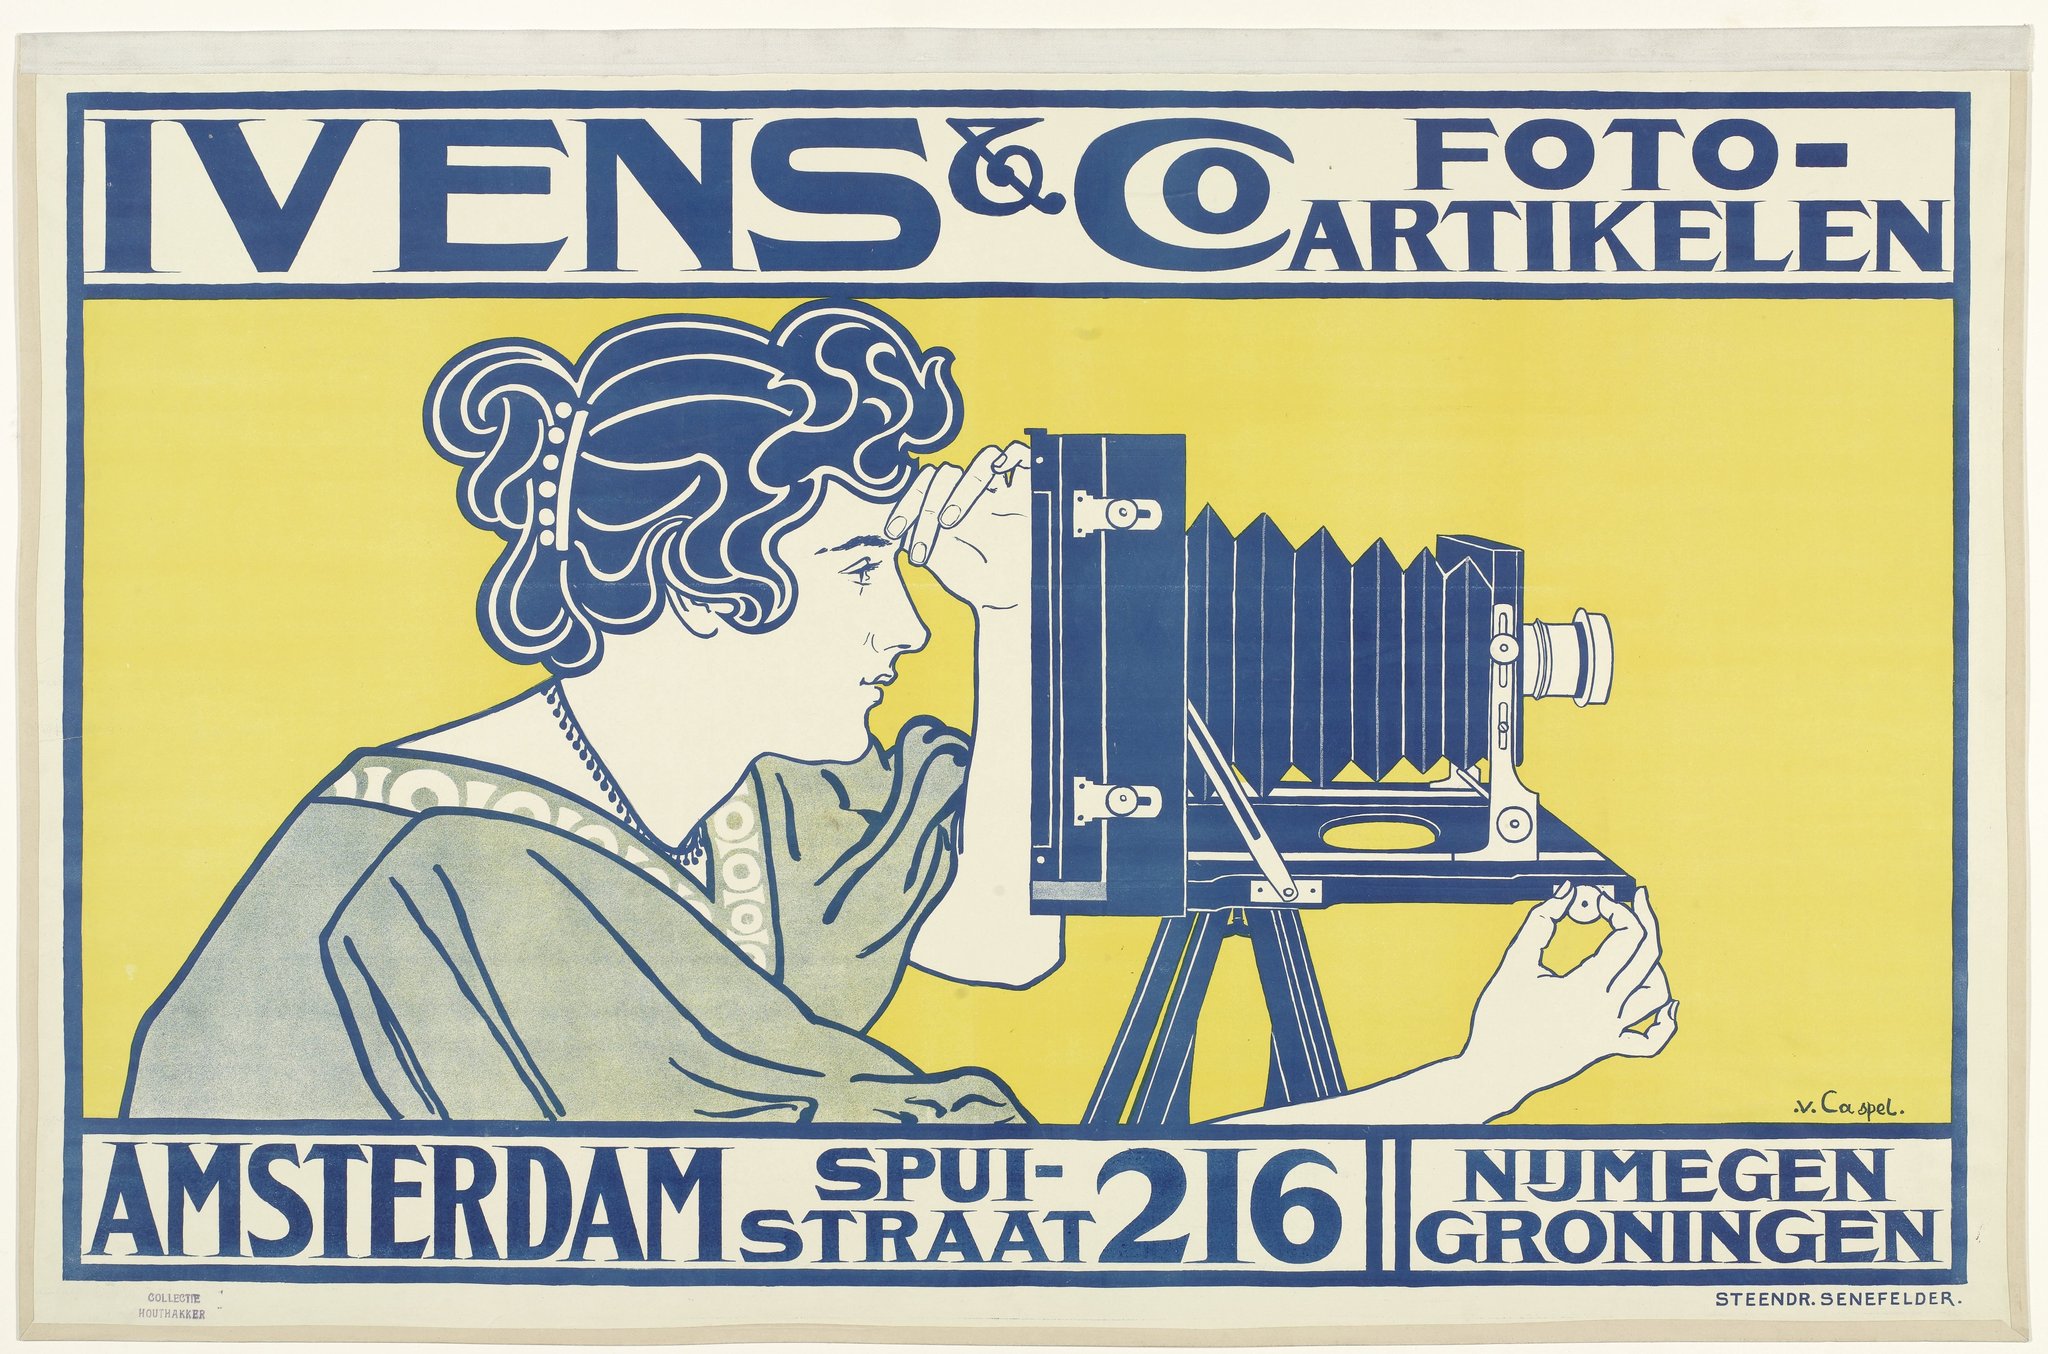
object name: poster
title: Advertising posters for Ivens & Co and Guy de Coral & Co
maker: johann georg van caspel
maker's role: draughtsman, print maker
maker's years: 1870-1928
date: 1899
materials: paper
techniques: lithograph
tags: photography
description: Chic shops for photographic articles, such as those of Guy de Coral and Ivens (the latter long known as CAPI), opened up in the cities. They engaged graphic designers to create a modern house style. The example of ‘Kitty, the Kodak girl’ in Eastman Kodak’s advertising campaigns was immediately adopted. The woman inspecting her glass negative in the darkroom graced the cover of Guy de Coral’s price list.